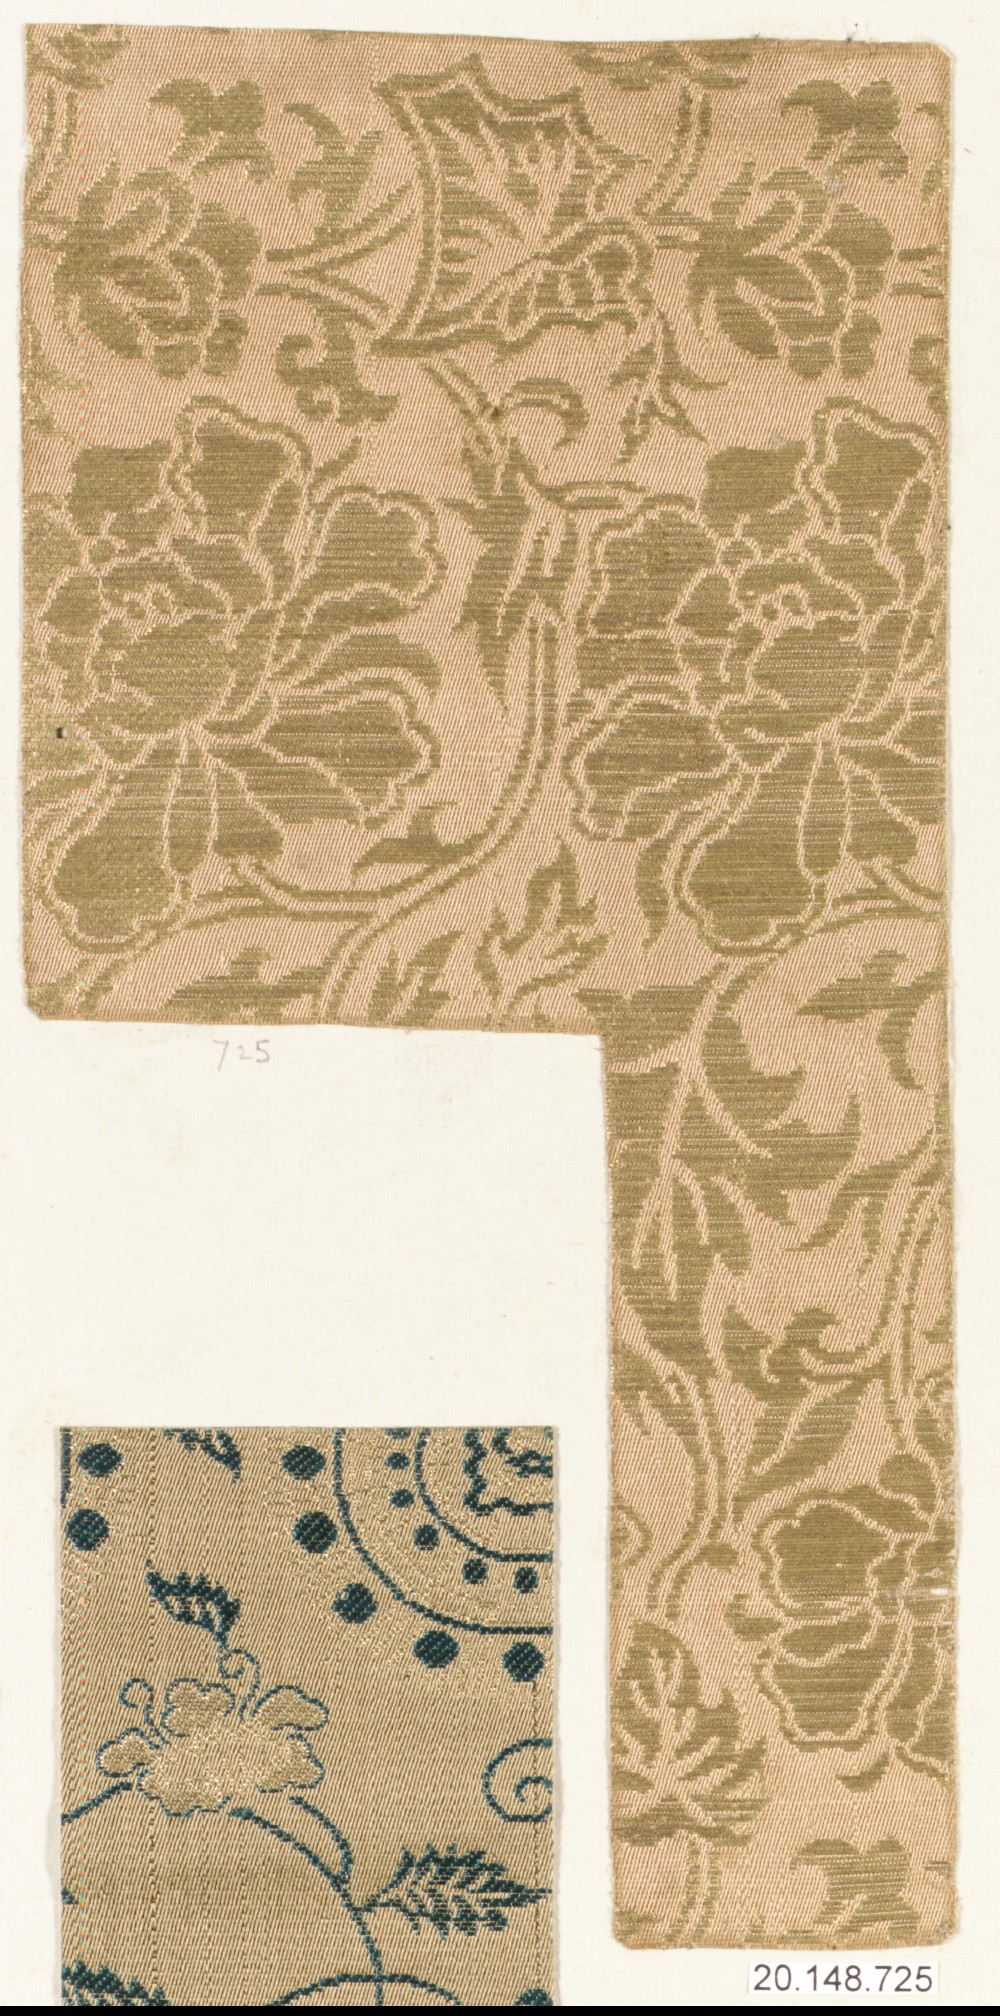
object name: piece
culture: japanese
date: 1601-1700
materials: silk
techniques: compound weave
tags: flowers,leaves